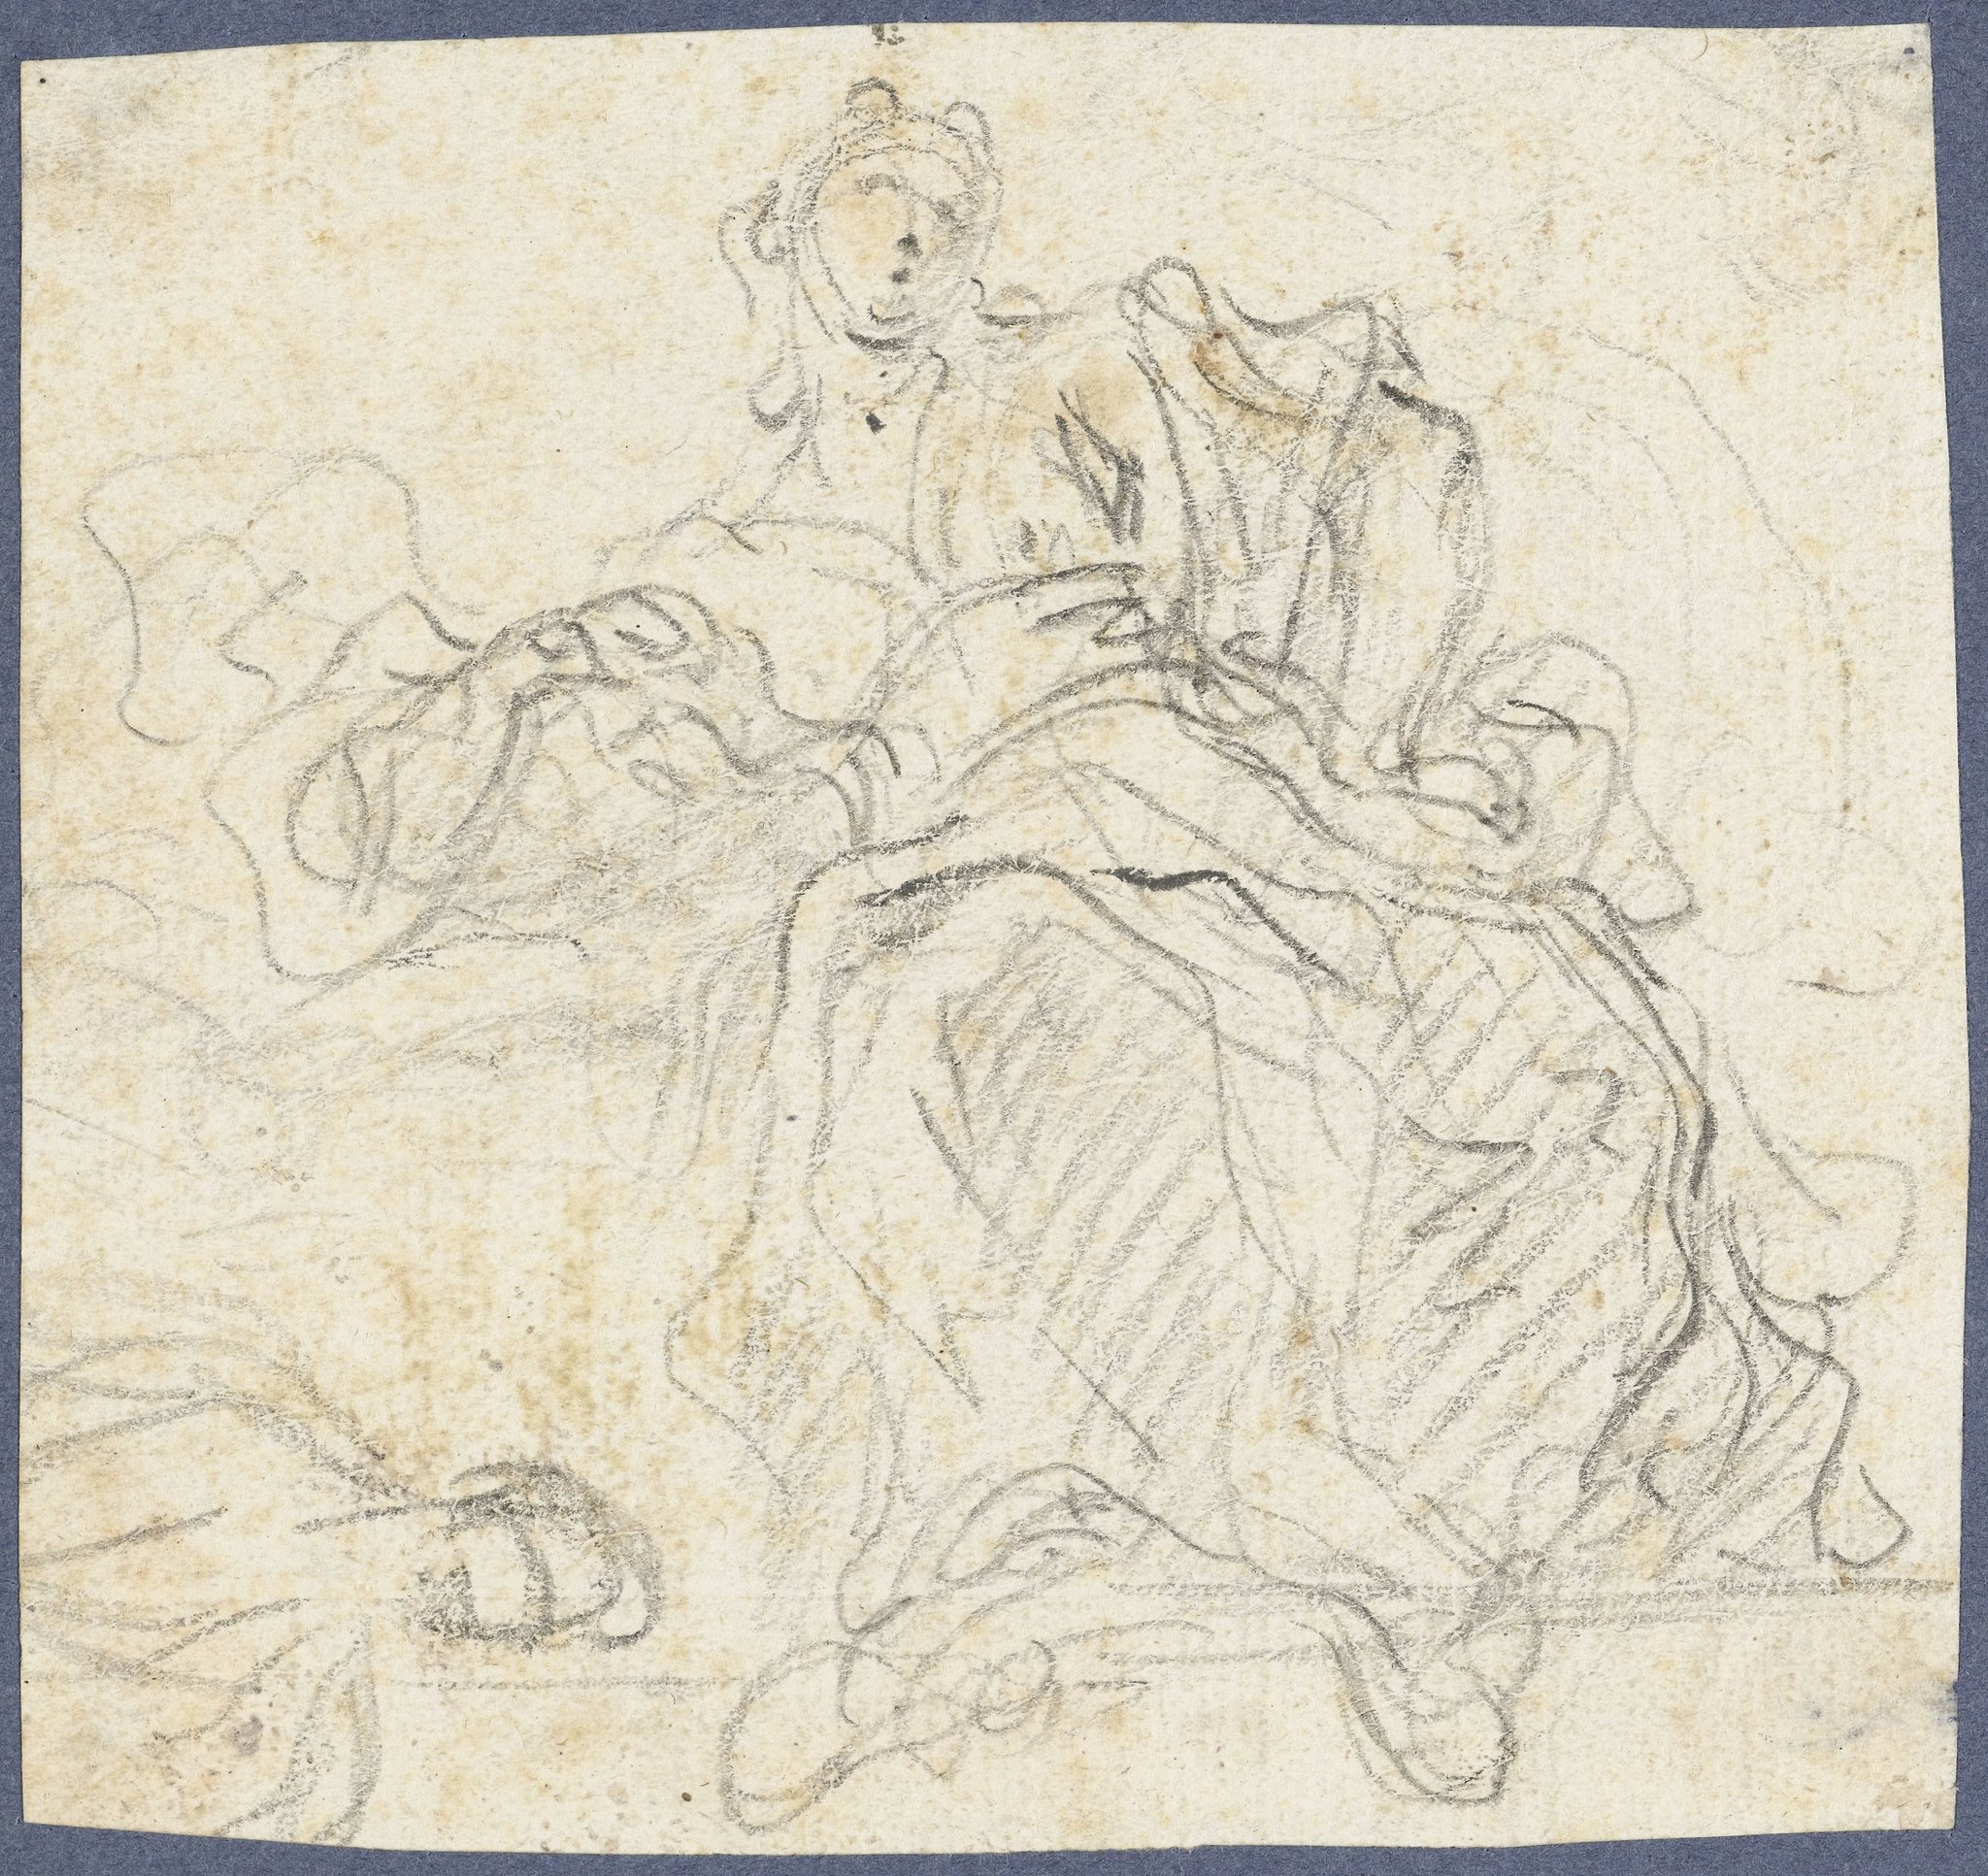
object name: drawing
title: Zittende vrouwenfiguur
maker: francesco solimena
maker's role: draughtsman, painter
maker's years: 1657-1747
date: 1667-1725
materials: chalk, paper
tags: sitting figure - aa - female human figure